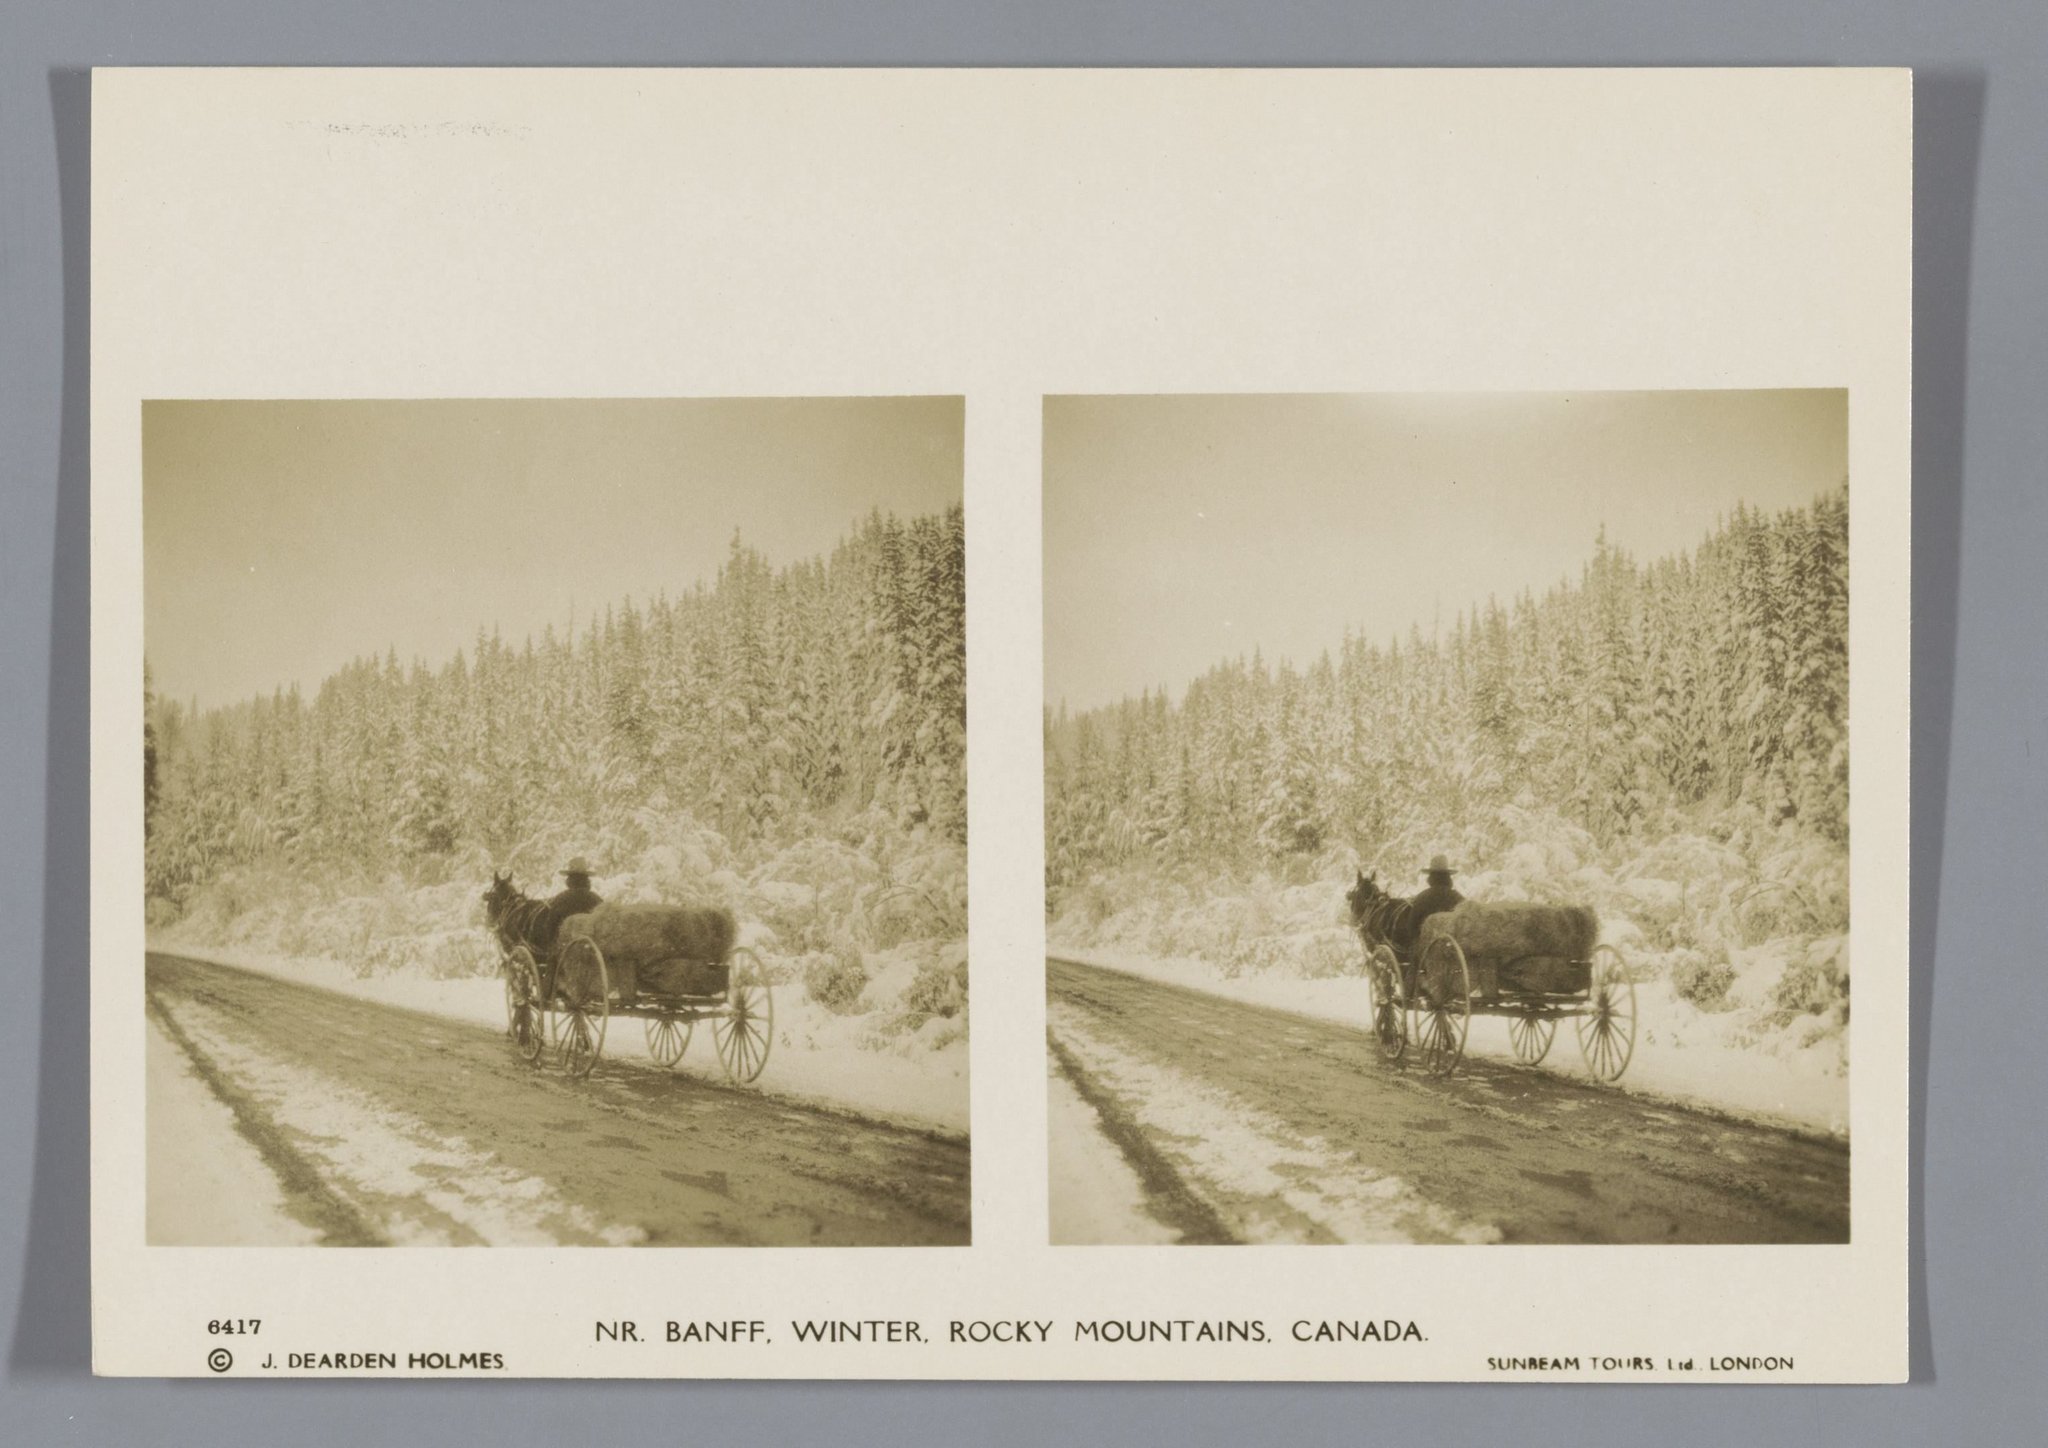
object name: stereograph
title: Nr. Banff, Winter, Rocky Mountains, Canada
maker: james dearden holmes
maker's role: fotograaf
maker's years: 1873-1937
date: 1924-1926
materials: paper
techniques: gelatin silver print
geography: london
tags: four-wheeled vehicle drawn by one animal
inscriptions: number: ‘6417’